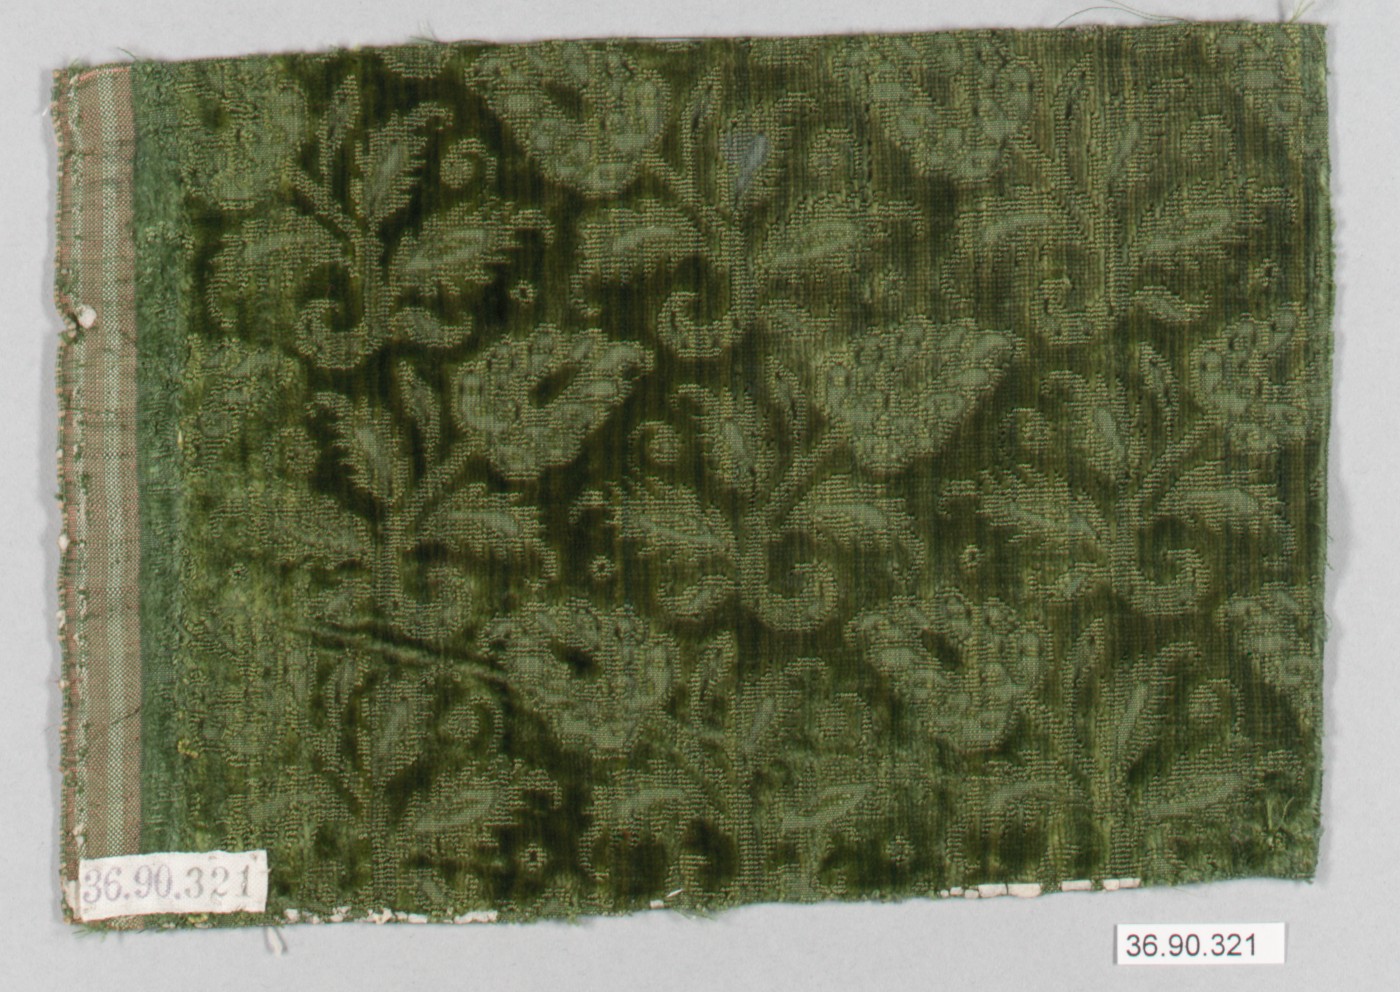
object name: piece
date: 1501-1700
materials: silk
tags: leaves